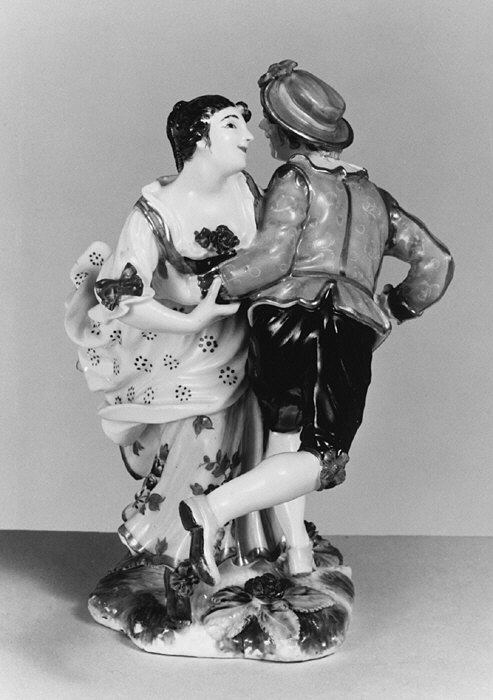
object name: group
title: Dutch dancers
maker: meissen manufactory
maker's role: manufactory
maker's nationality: german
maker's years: 1710-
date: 1740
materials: hard paste porcelain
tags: men,women,dancers